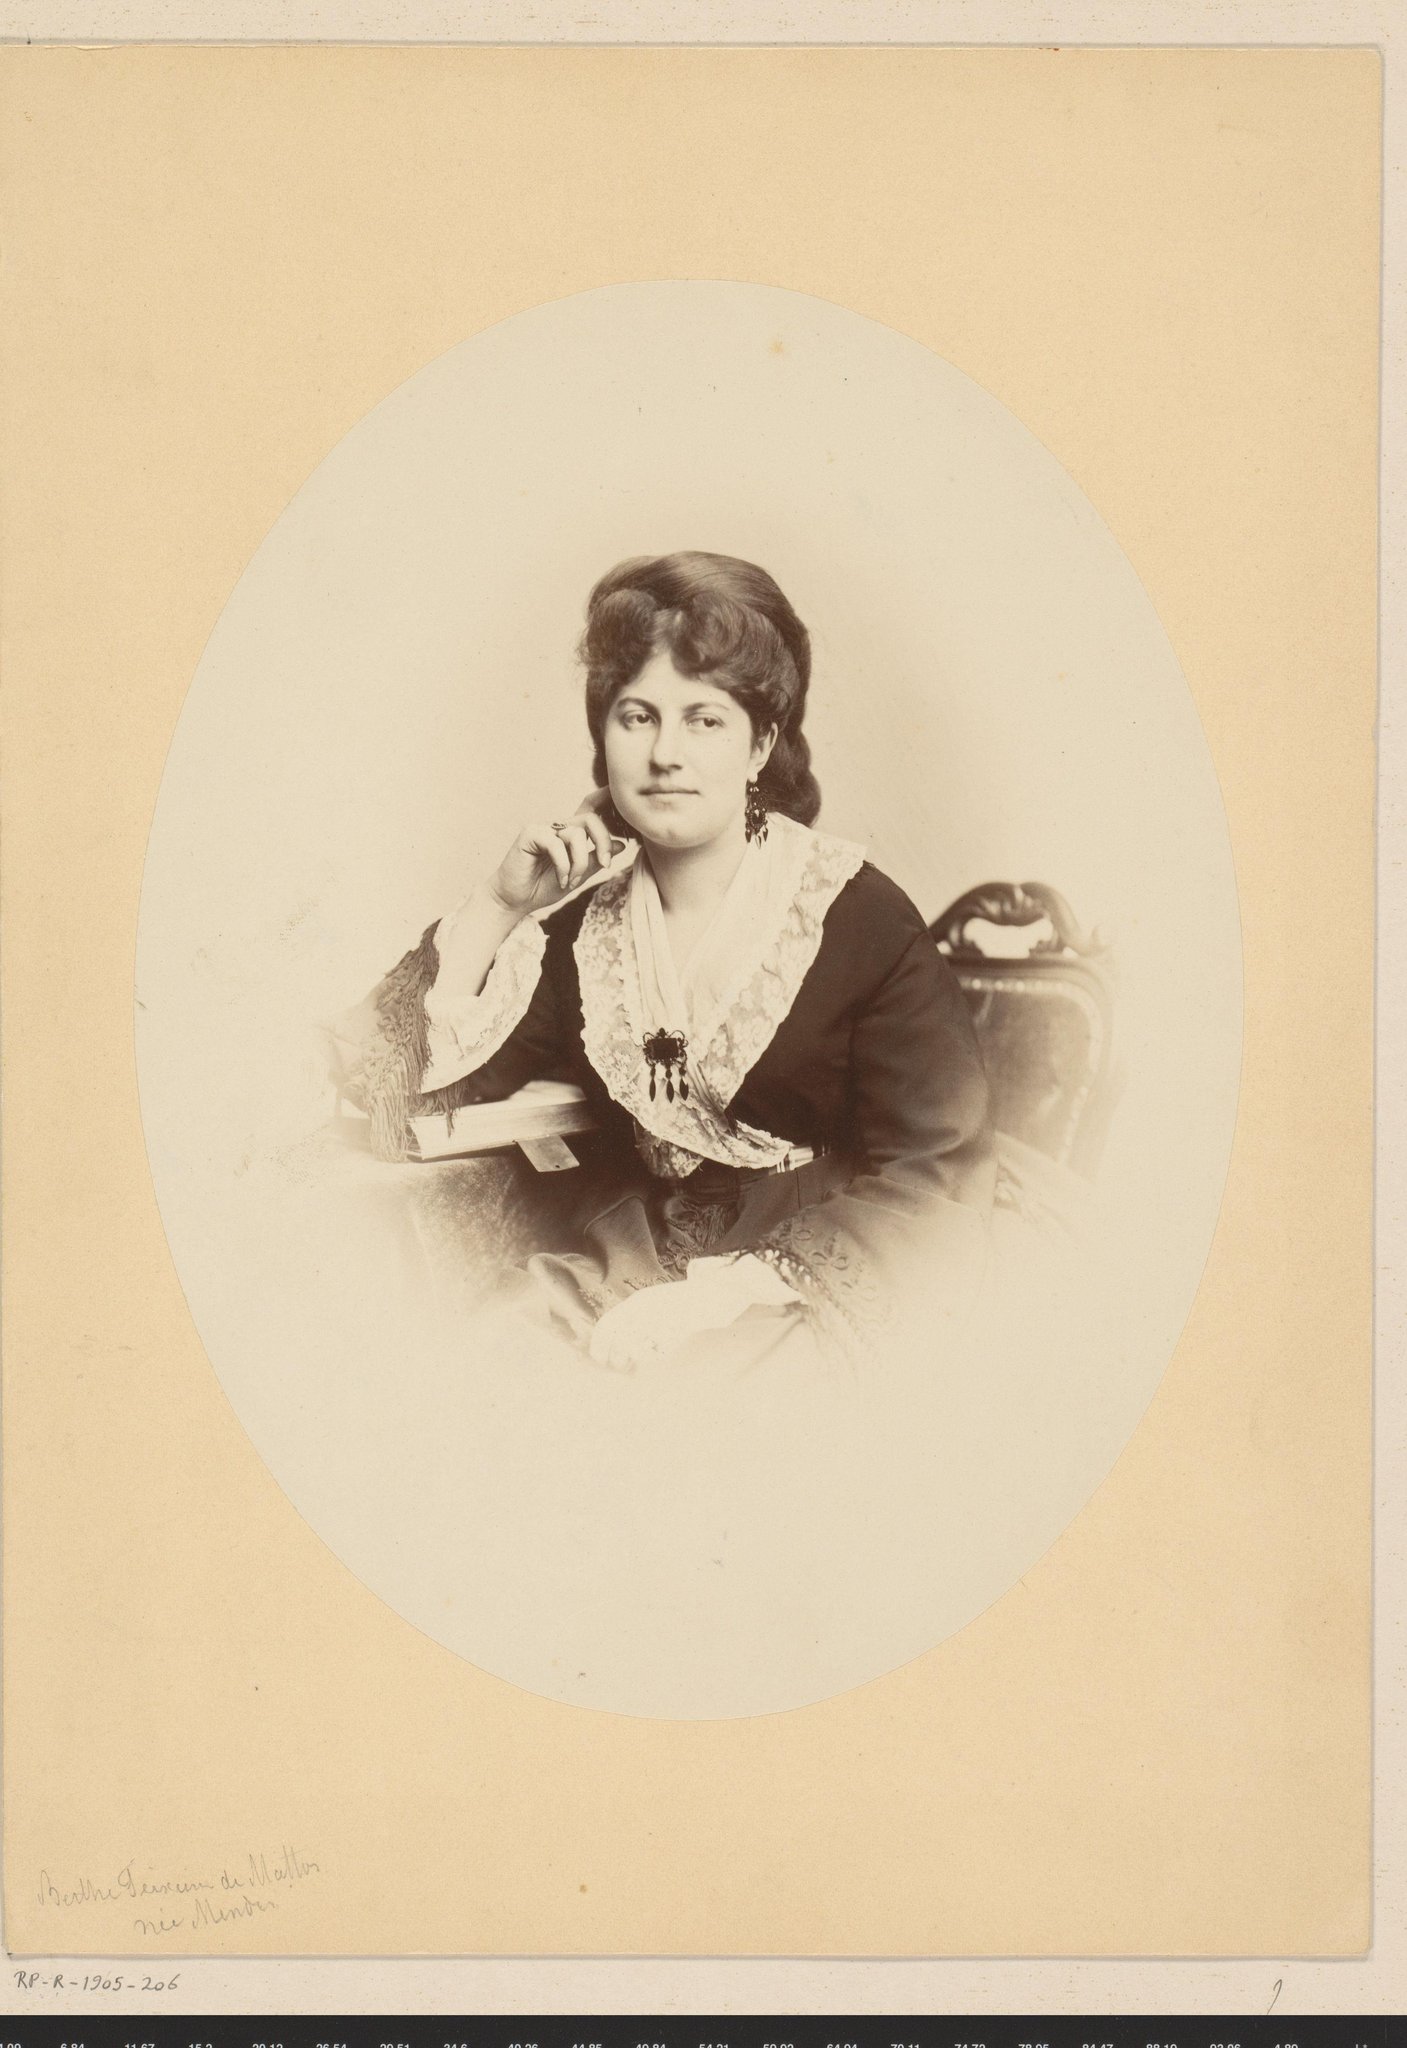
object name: photograph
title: Portret van Bertha Teixeira de Mattos-Mendes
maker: Anonymous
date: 1890-1905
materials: cardboard, paper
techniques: albumen print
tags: historical persons - bb - woman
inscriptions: inscription: ‘Bertha Teixeira de Mattos/ née Mendes’, collector's mark: Lugt 2228